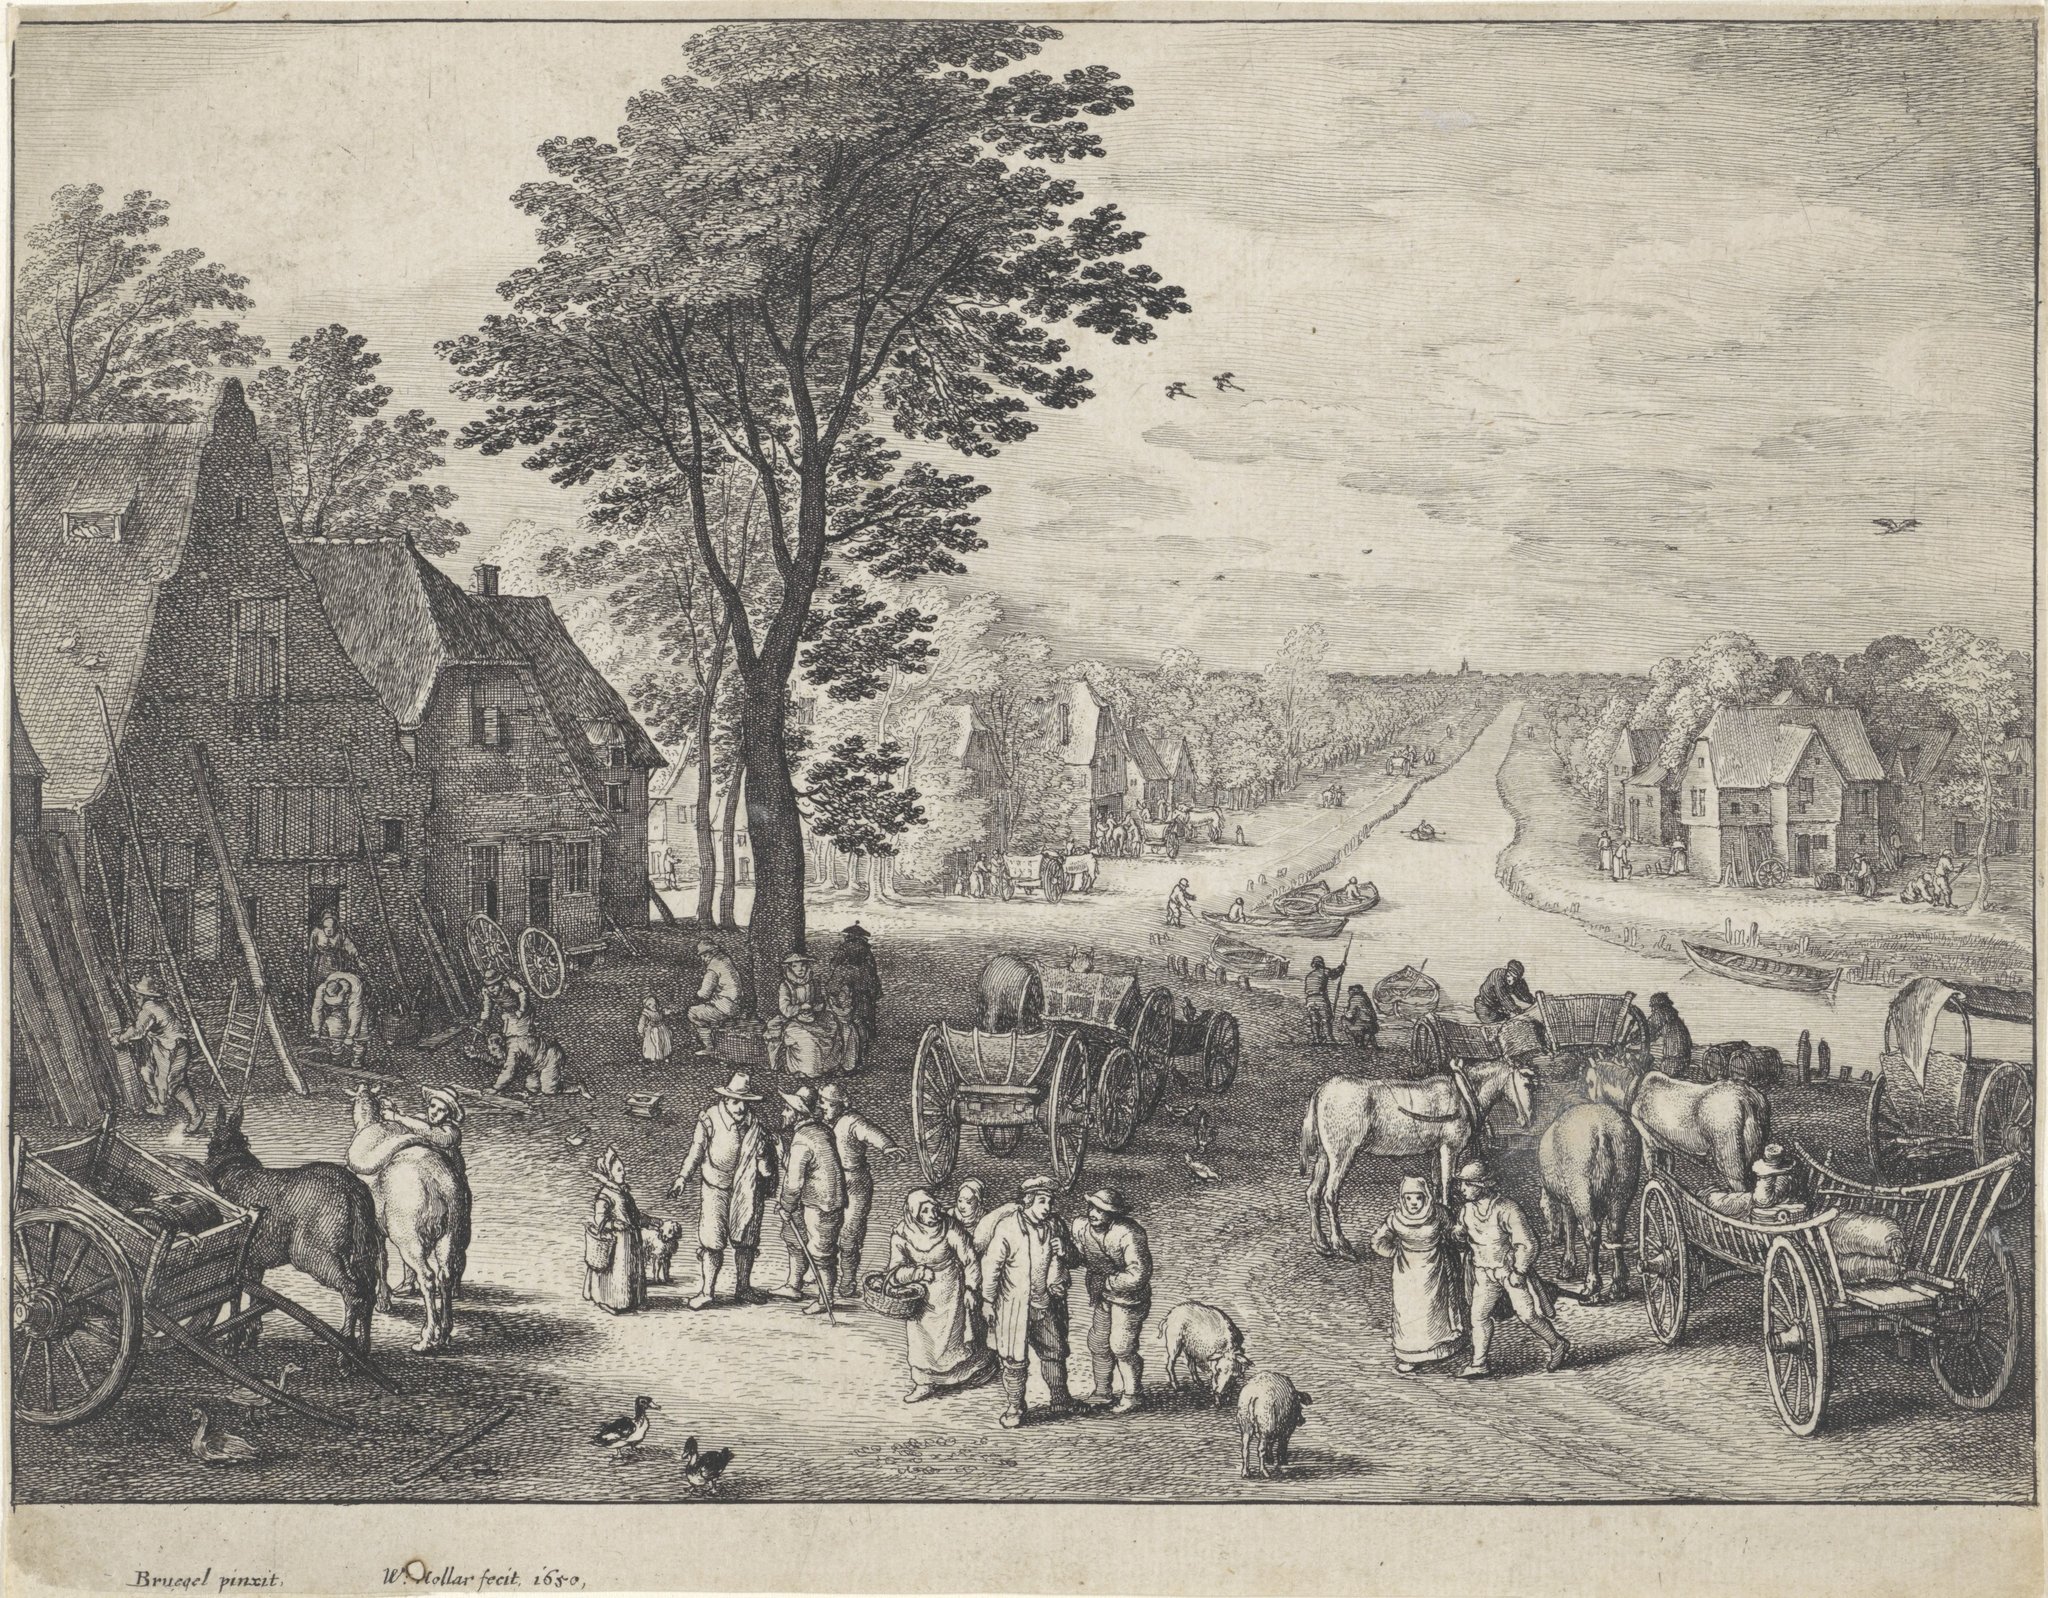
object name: print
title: Dorpsgezicht met recht kanaal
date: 1650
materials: paper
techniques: etching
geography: antwerp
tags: canals, waters (in village), village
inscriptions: collector's mark: Lugt 240